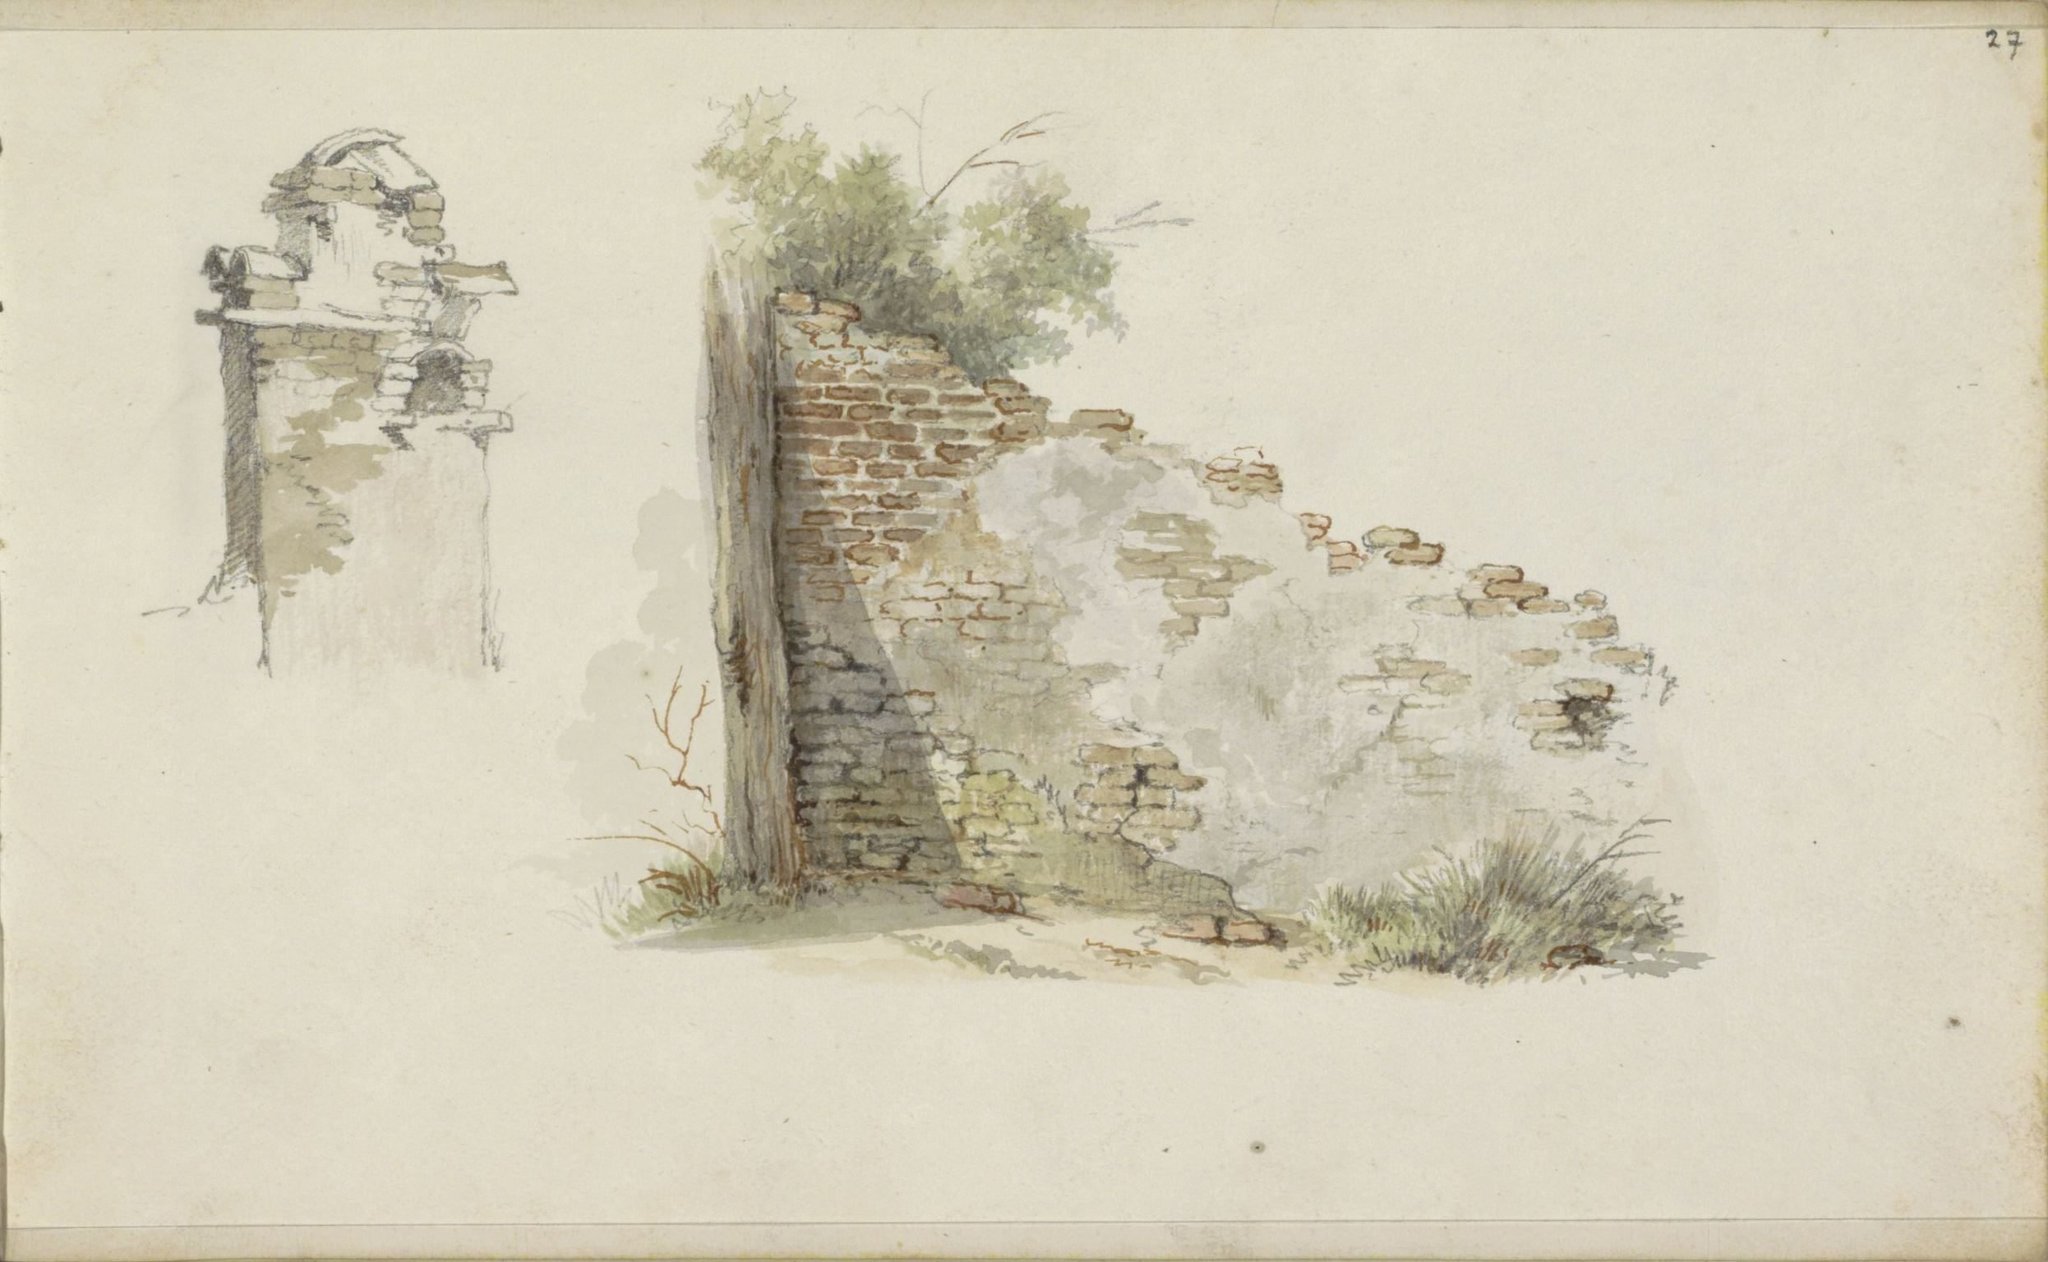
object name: sketchbook leaf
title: Vervallen muur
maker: adrianus eversen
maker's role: draughtsman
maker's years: 1818-1897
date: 1828-1897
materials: paper, pencil, watercolor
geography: netherlands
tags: ruin of a building ~ architecture, fence, wall, paling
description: Links een onderdeel van een muur. Rechts een vervallen muur. Blad 27 recto uit een schetsboek met 27 bladen.